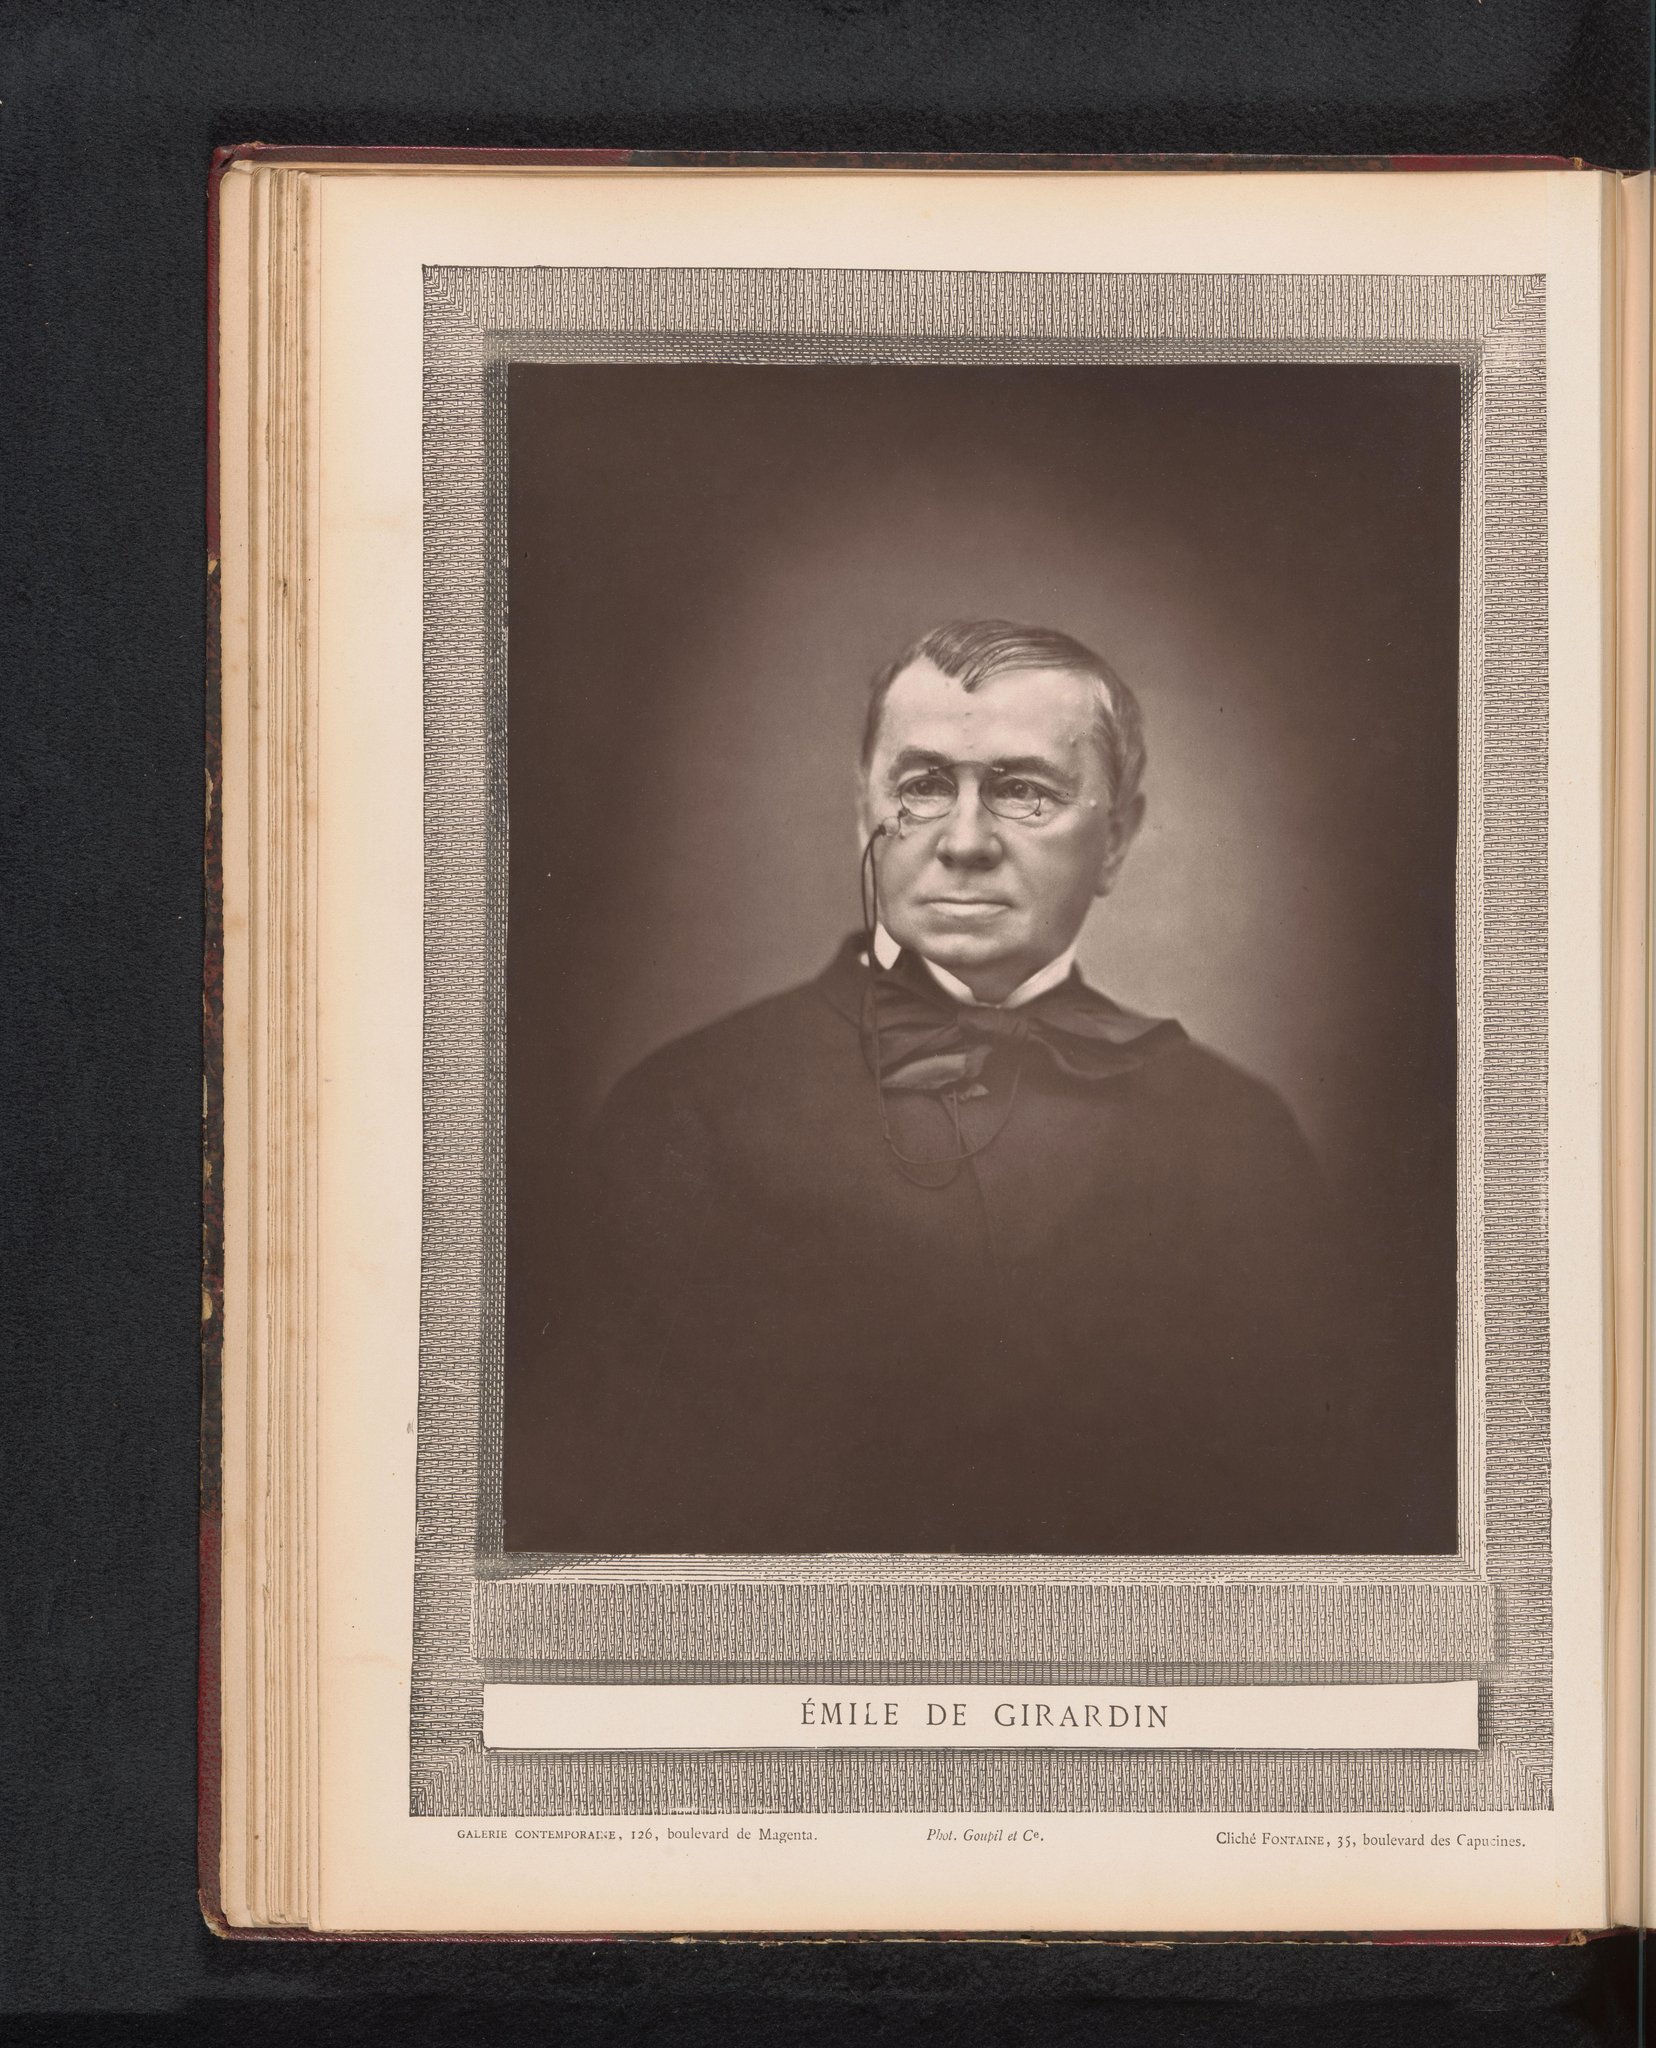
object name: photomechanical print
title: Portret van Émile de Girardin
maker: fontaine (fotograaf)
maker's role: clichémaker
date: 1871-1876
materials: paper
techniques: woodburytype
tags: publisher, émile de girardin, adult man, historical persons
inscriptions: inscription: ‘Galerie Contemporaine, 126, boulevard de Magenta.’